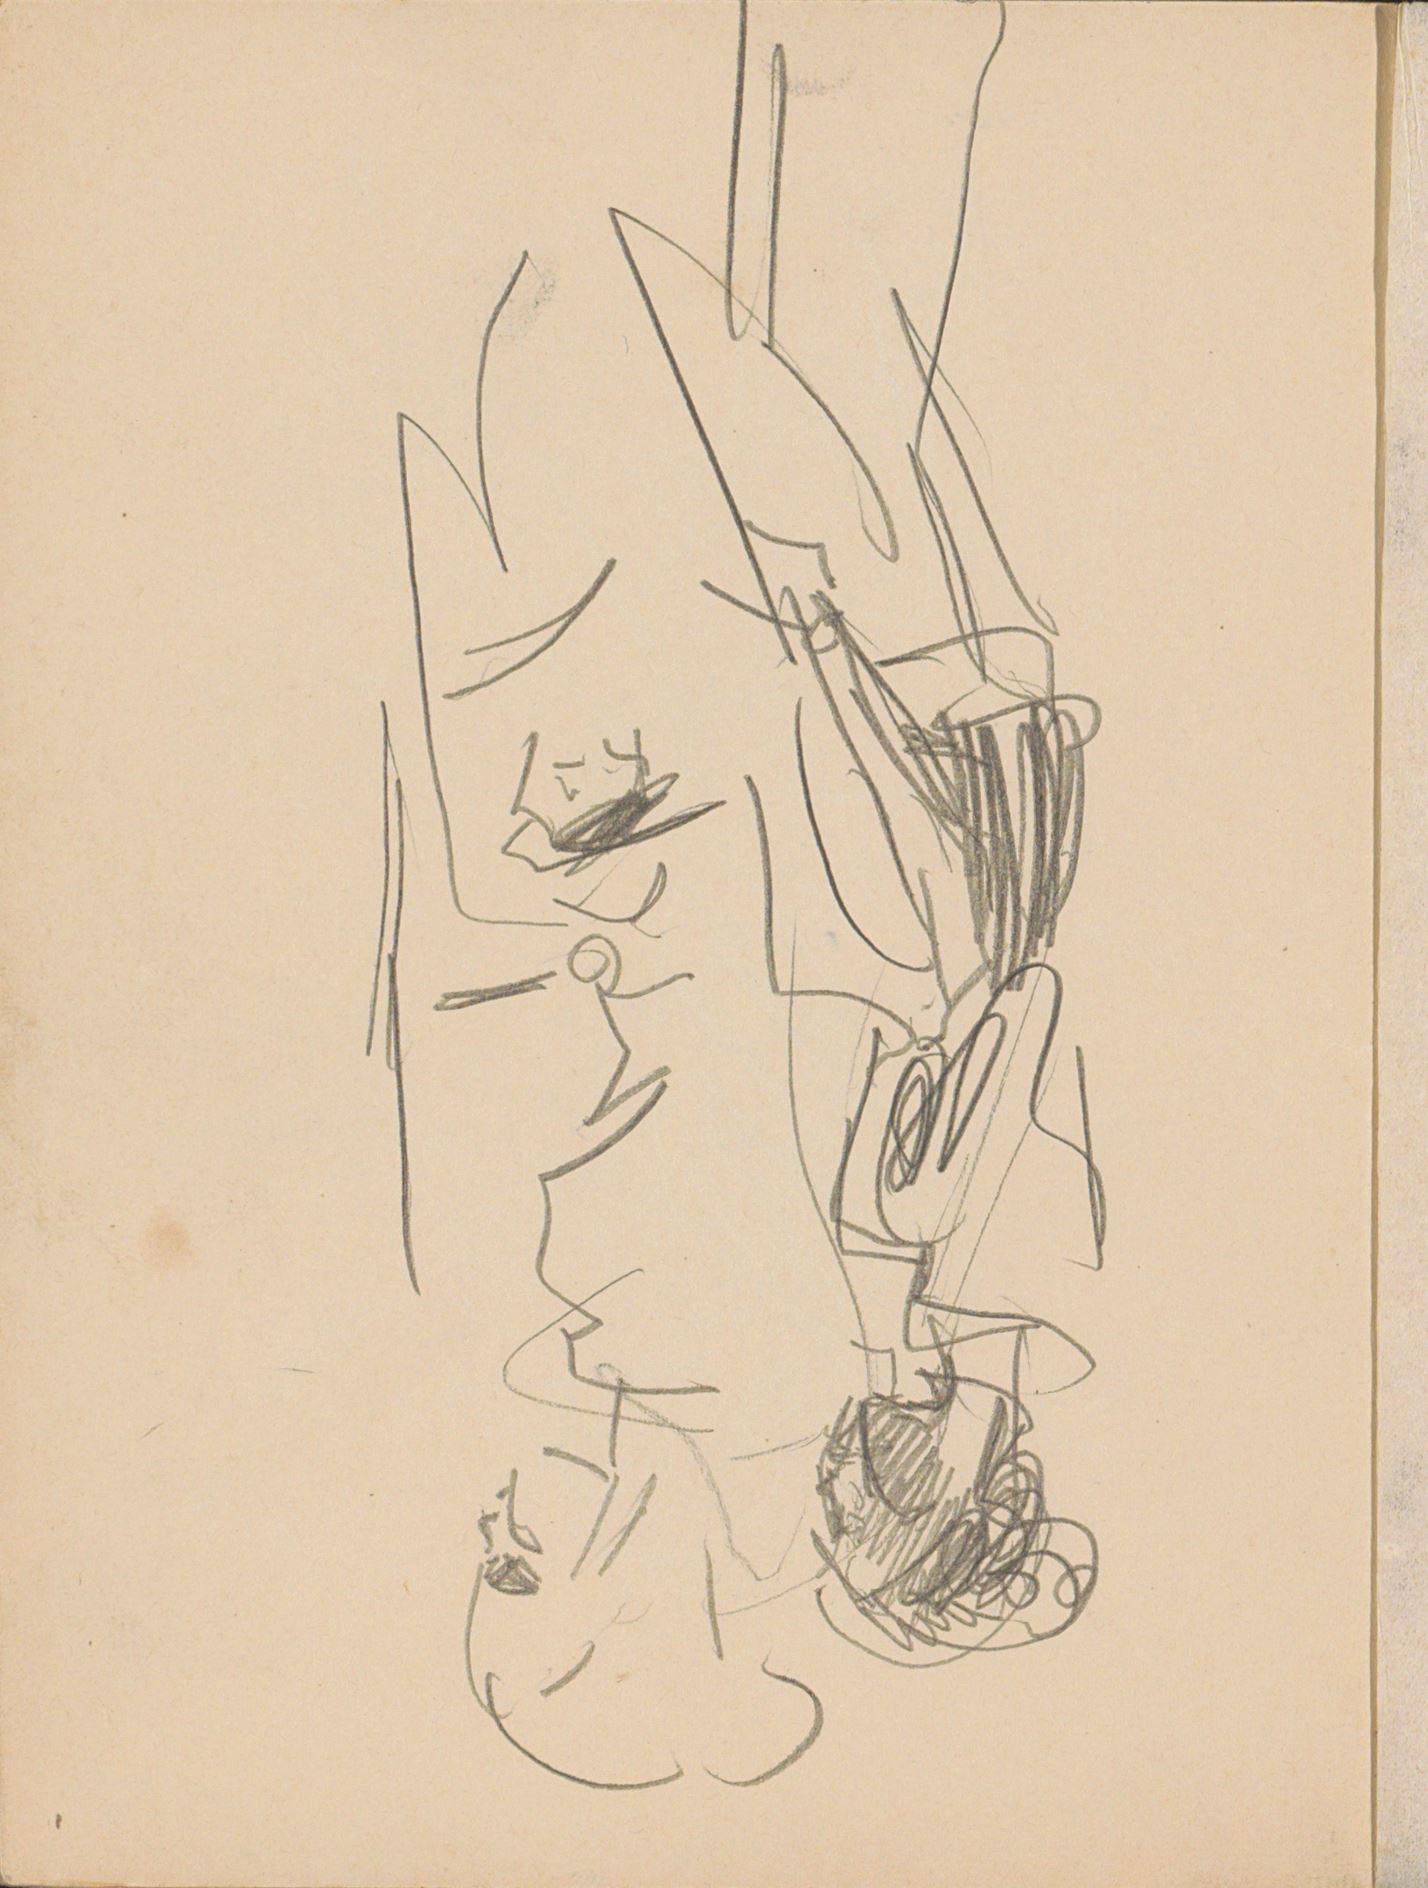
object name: sketchbook leaf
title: Twee studies van een staande vrouw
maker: isaac israels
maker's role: draughtsman, painter, print maker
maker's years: 1865-1934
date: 1921-1922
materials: paper, pencil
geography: dutch east indies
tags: asiatic races and peoples, adult woman (+ standing), dutch east indies, the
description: Indische figuurstudies. Pagina 12 uit schetsboek XXXIV met 24 pagina's.